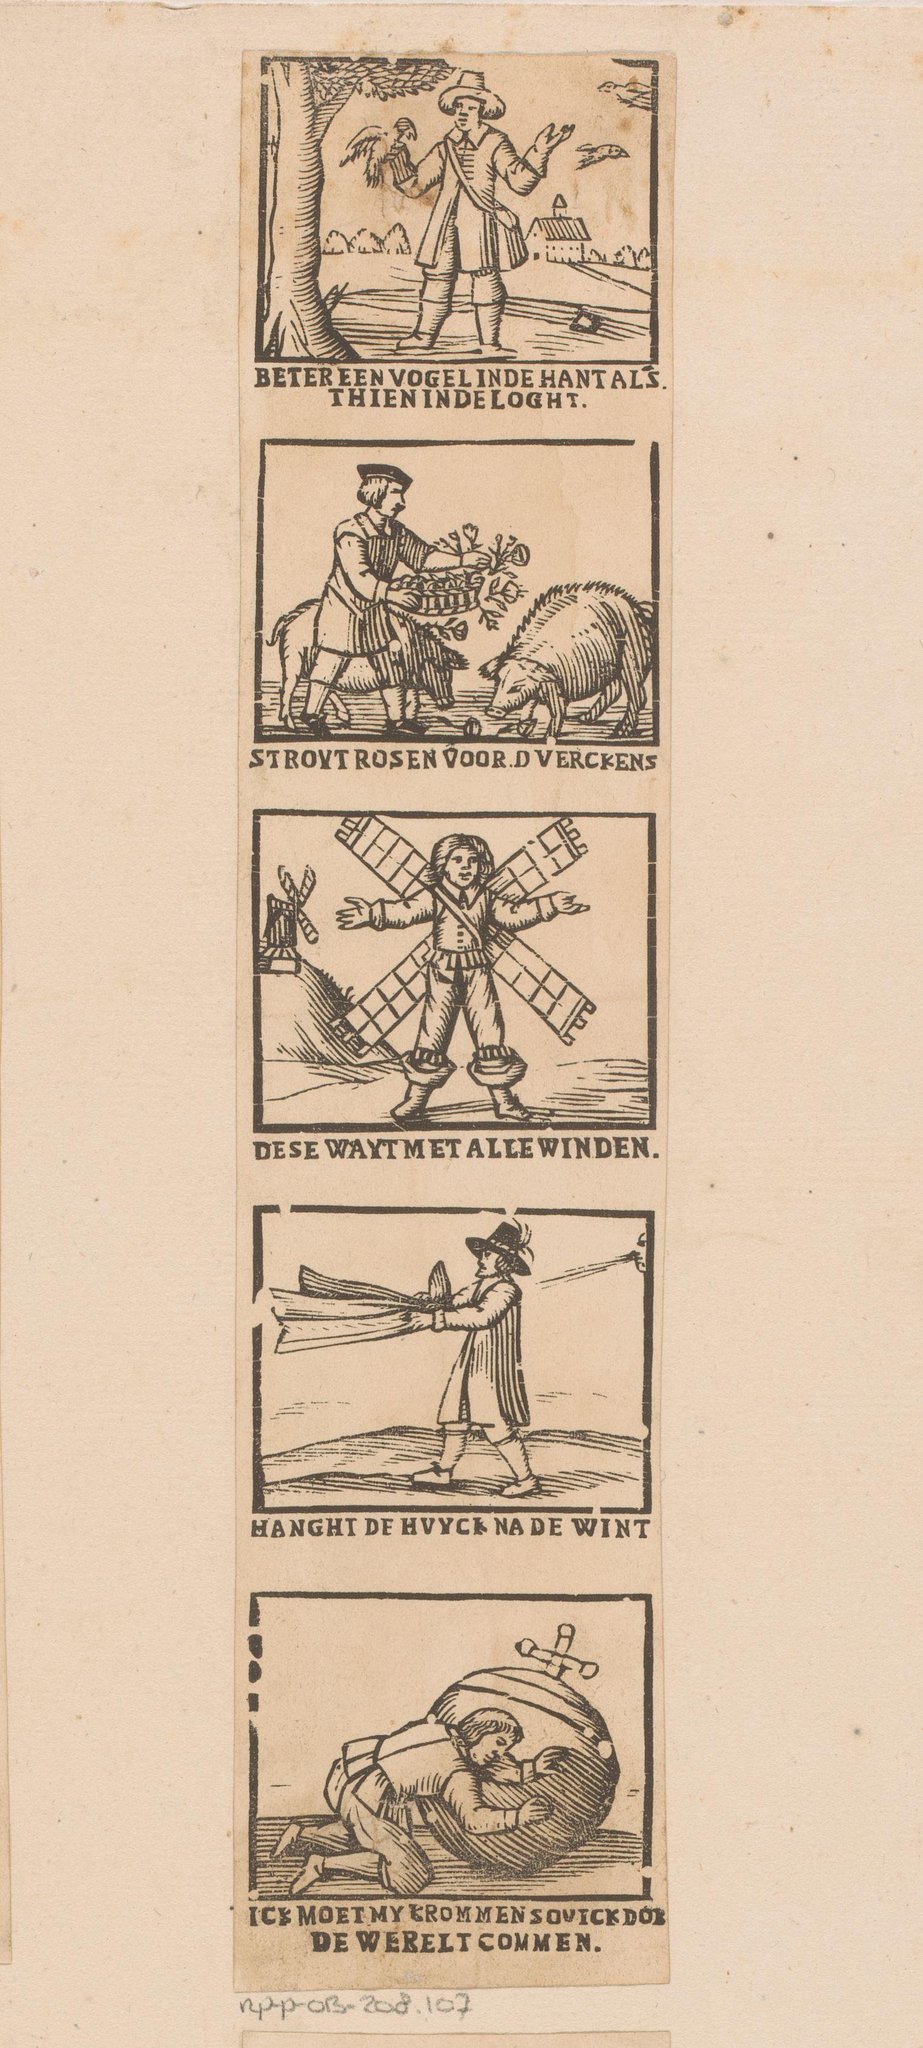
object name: popular print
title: Afbeeldingh hoe seven wyven vechten om een mans broeck ende de vrou de broeck aentrecht [(...)]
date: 1700-1725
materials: paper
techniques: woodcut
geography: low countries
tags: proverbs, sayings, etc.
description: Blad met 5 voorstellingen van spreekwoorden, waaronder 'Beter een vogel in de hant als thien in de loght' en 'Dese wayt met alle winden'. Onder elke afbeelding een onderschrift.